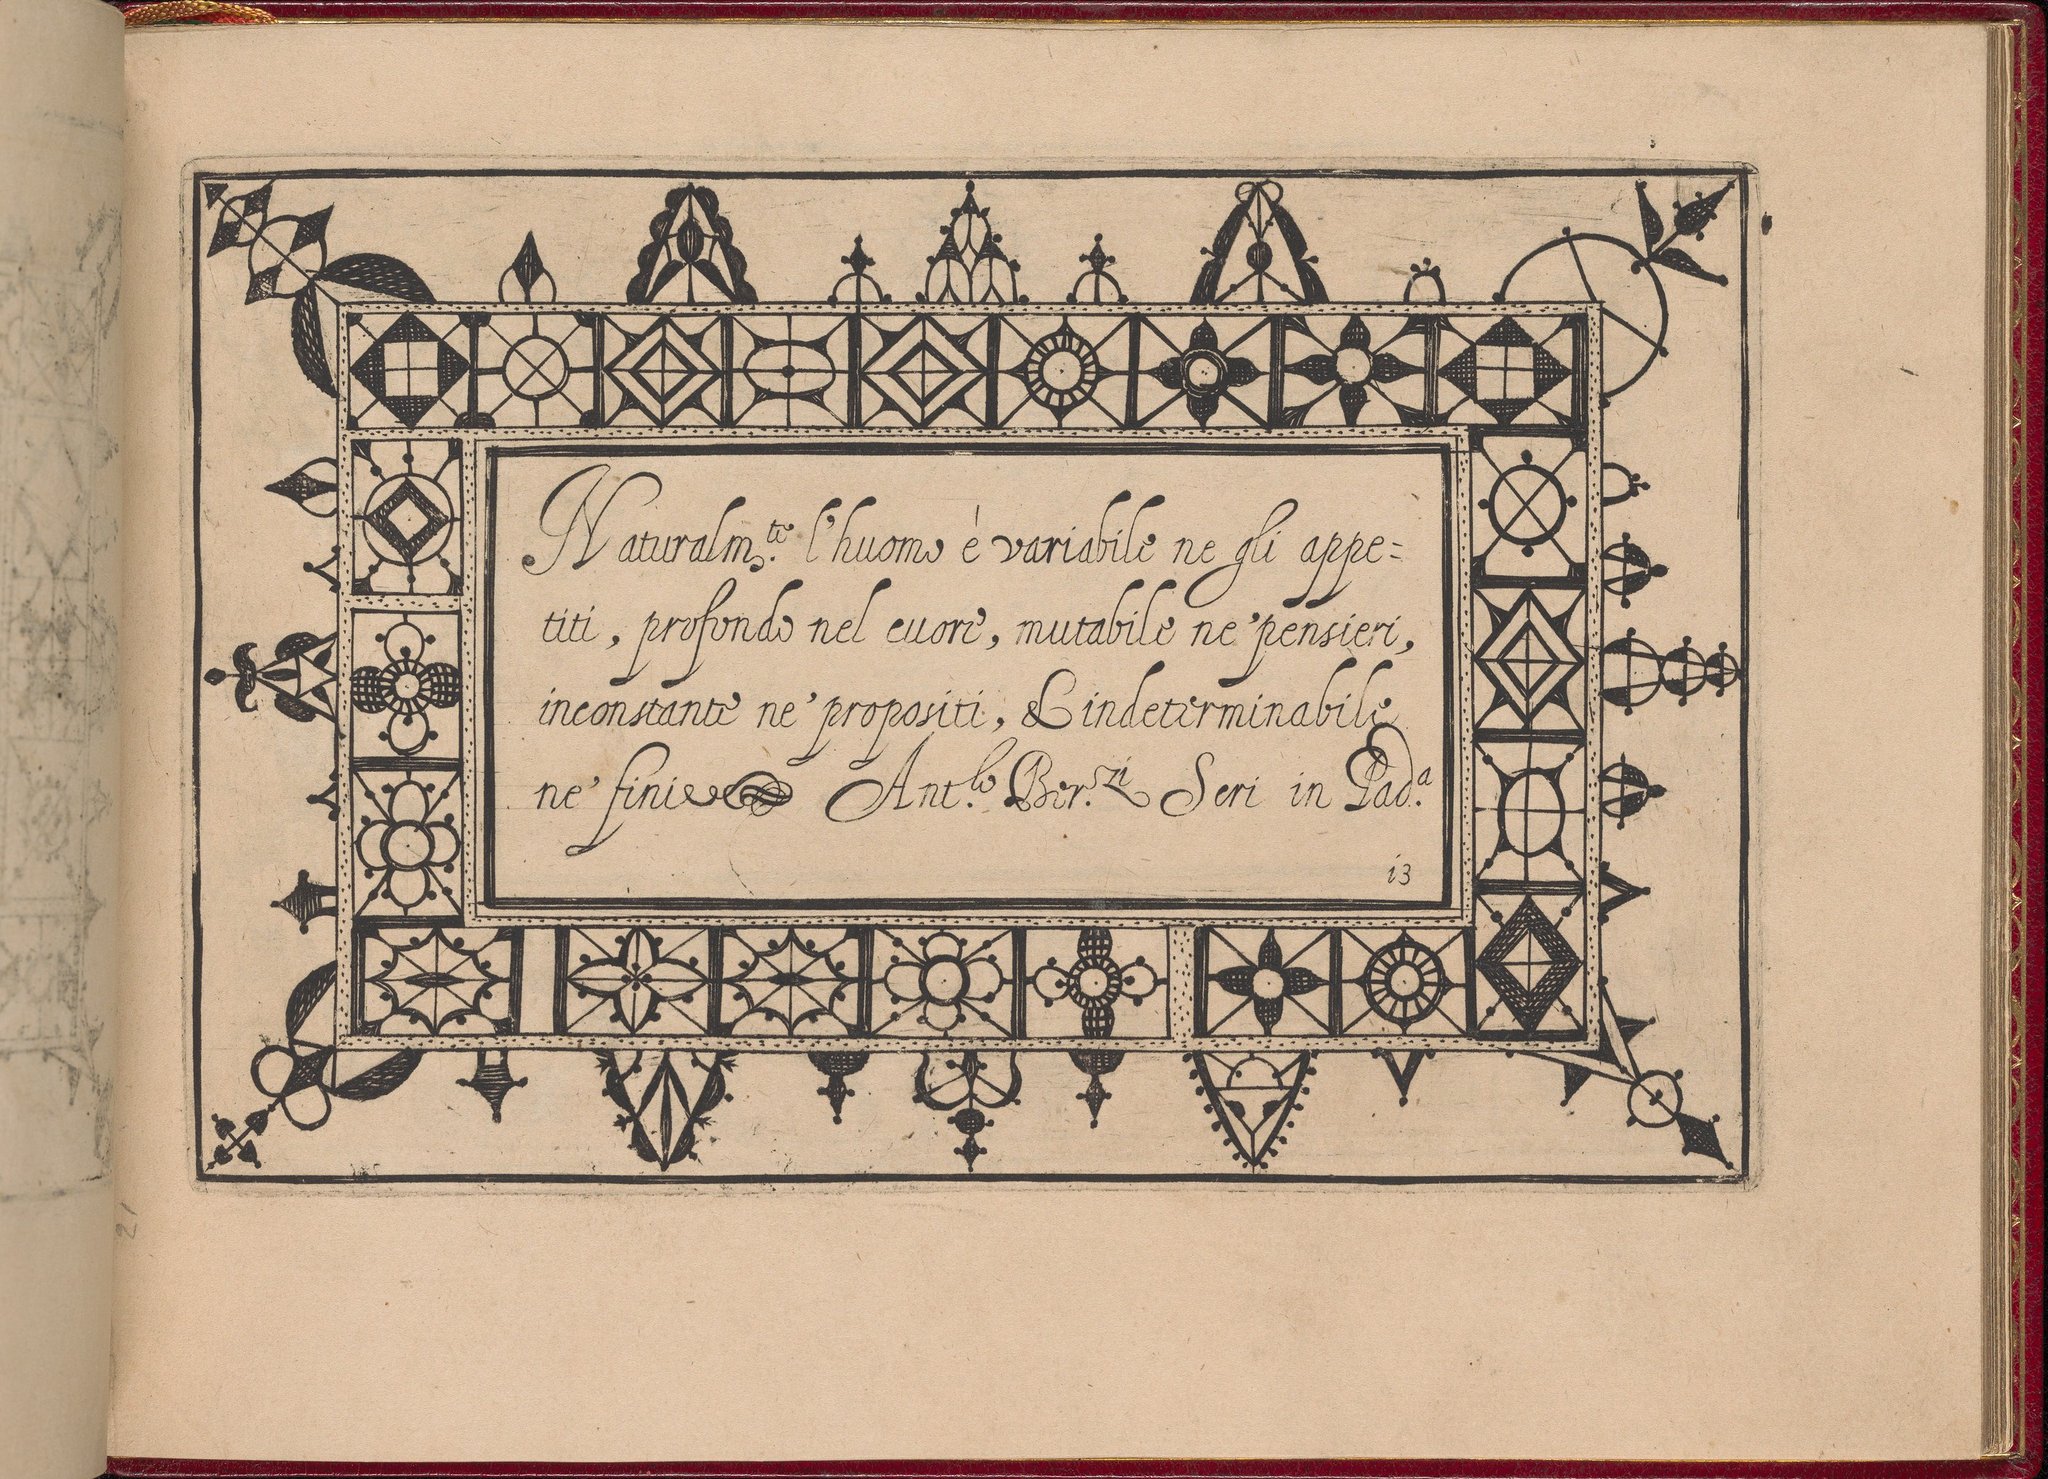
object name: book print ornament architecture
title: Ghirlanda: Di sei vaghi fiori scielti da piu famosi Giardini d'Italia, page 21 (recto)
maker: pietro paulo tozzi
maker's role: designer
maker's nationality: italian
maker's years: 1593-1628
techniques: drawing, etching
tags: ornament